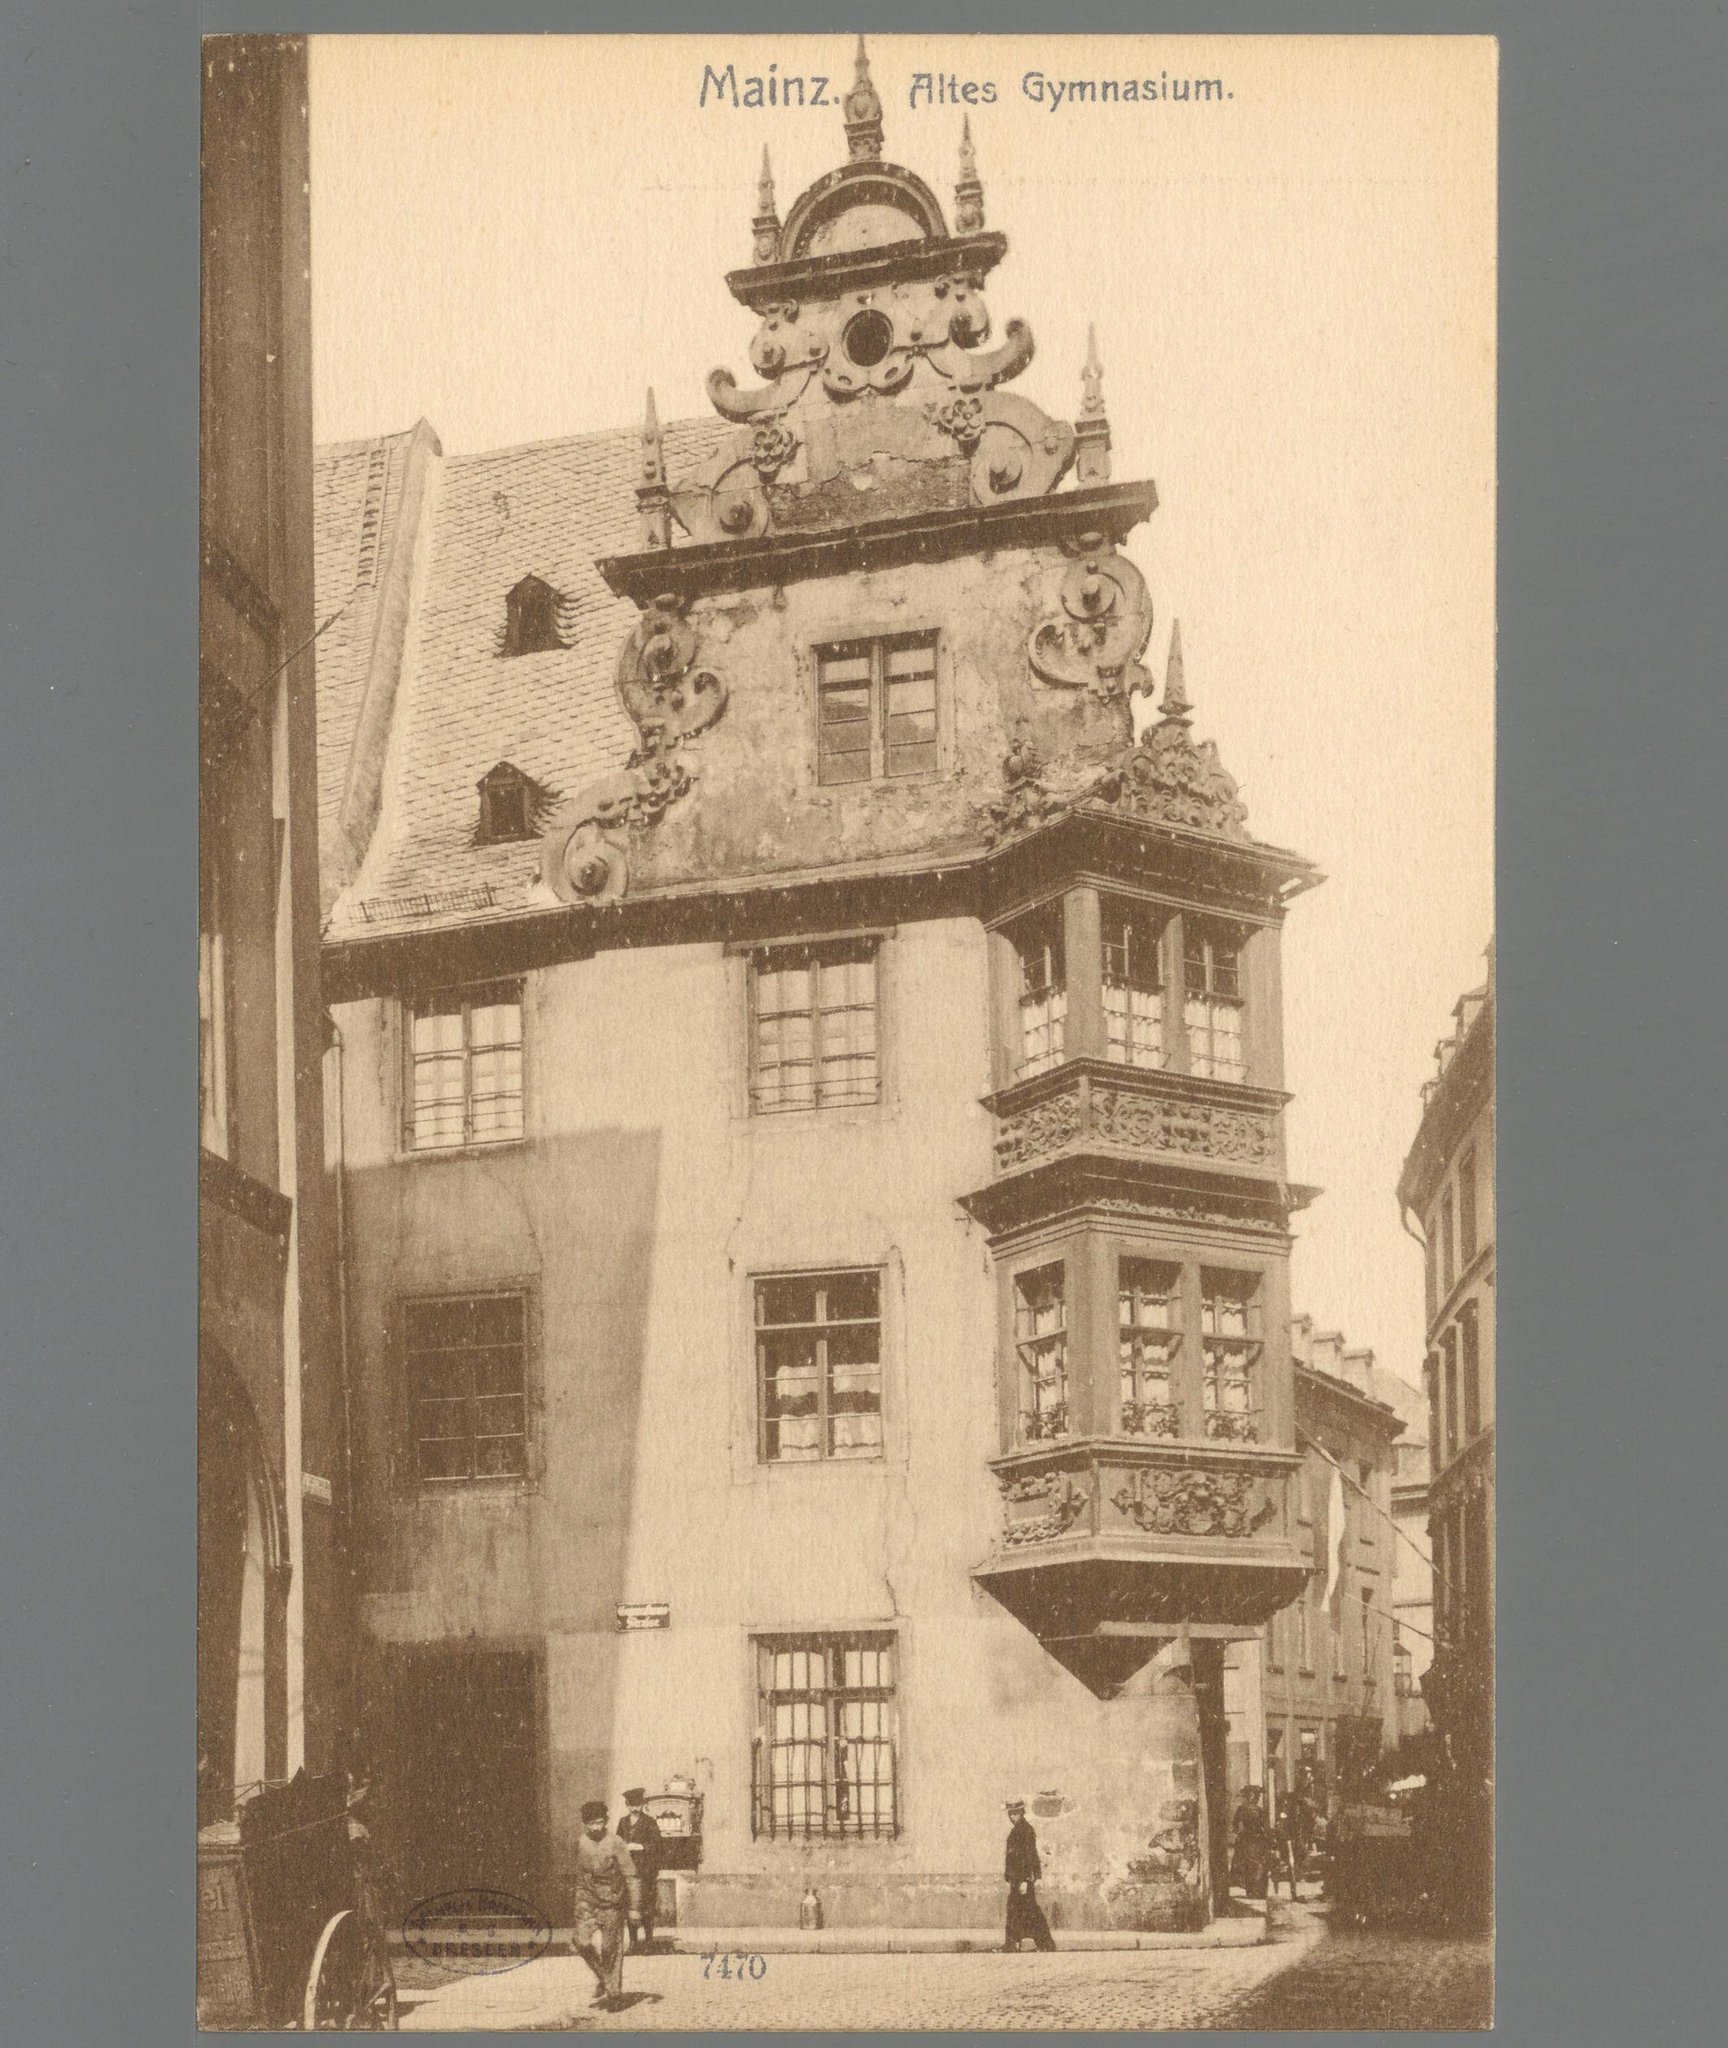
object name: ansichtkaart, prentbriefkaart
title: Mainz. Altes Gymnasium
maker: Anonymous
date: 1905-1908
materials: cardboard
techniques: photograph, writing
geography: dresden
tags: university building, college